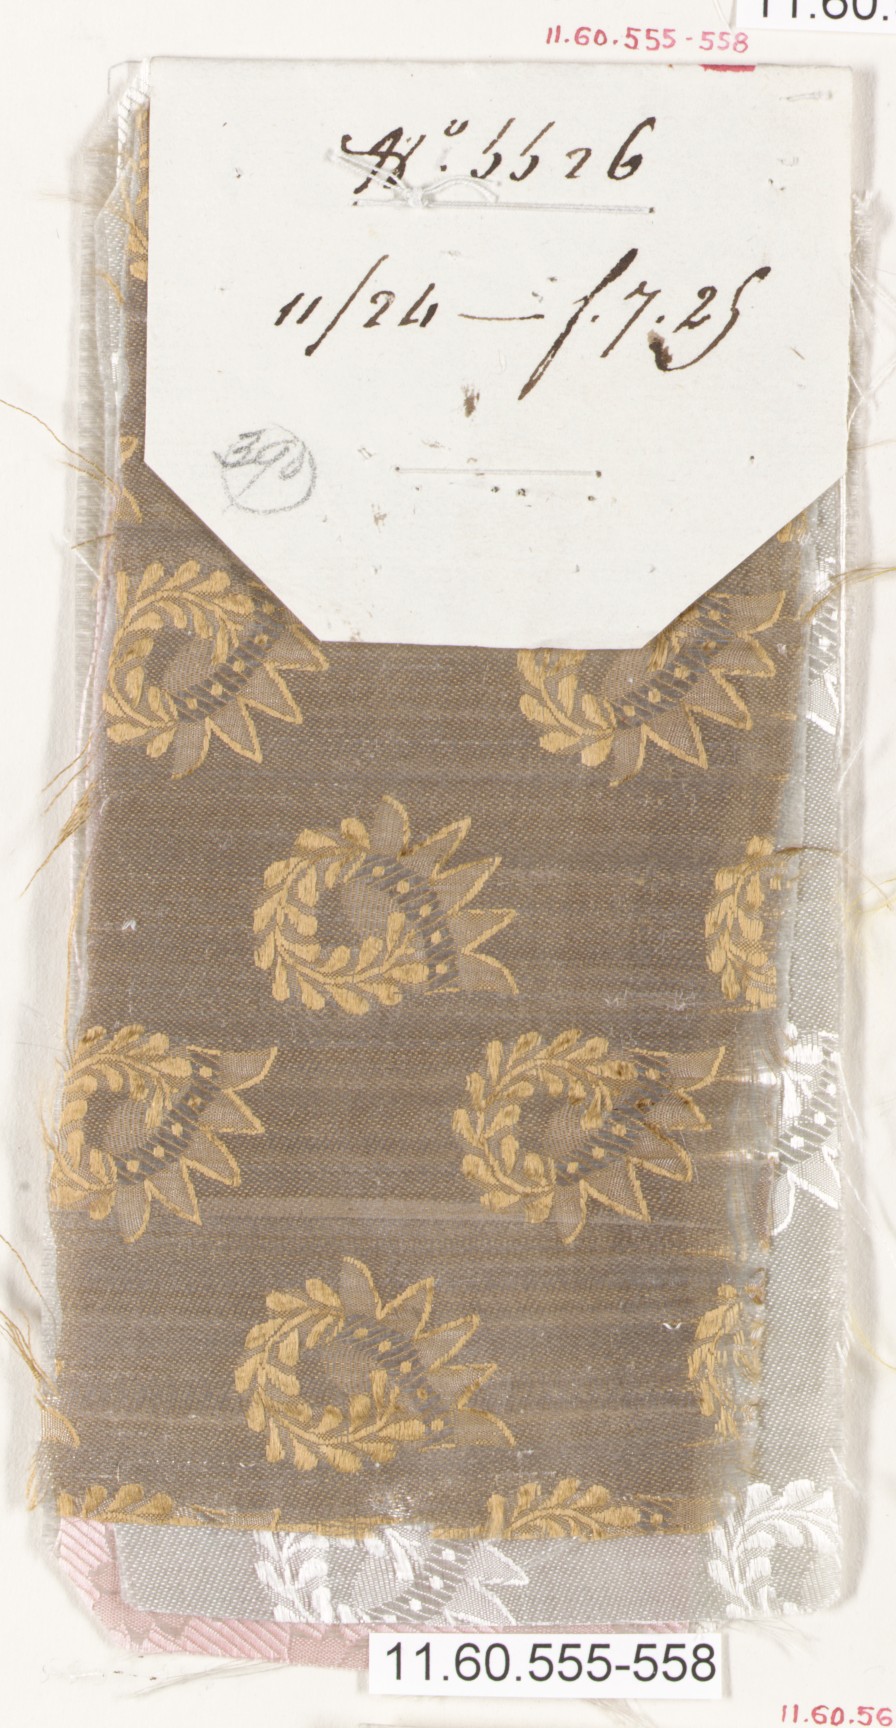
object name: sample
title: Samples (3)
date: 1801-1850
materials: silk